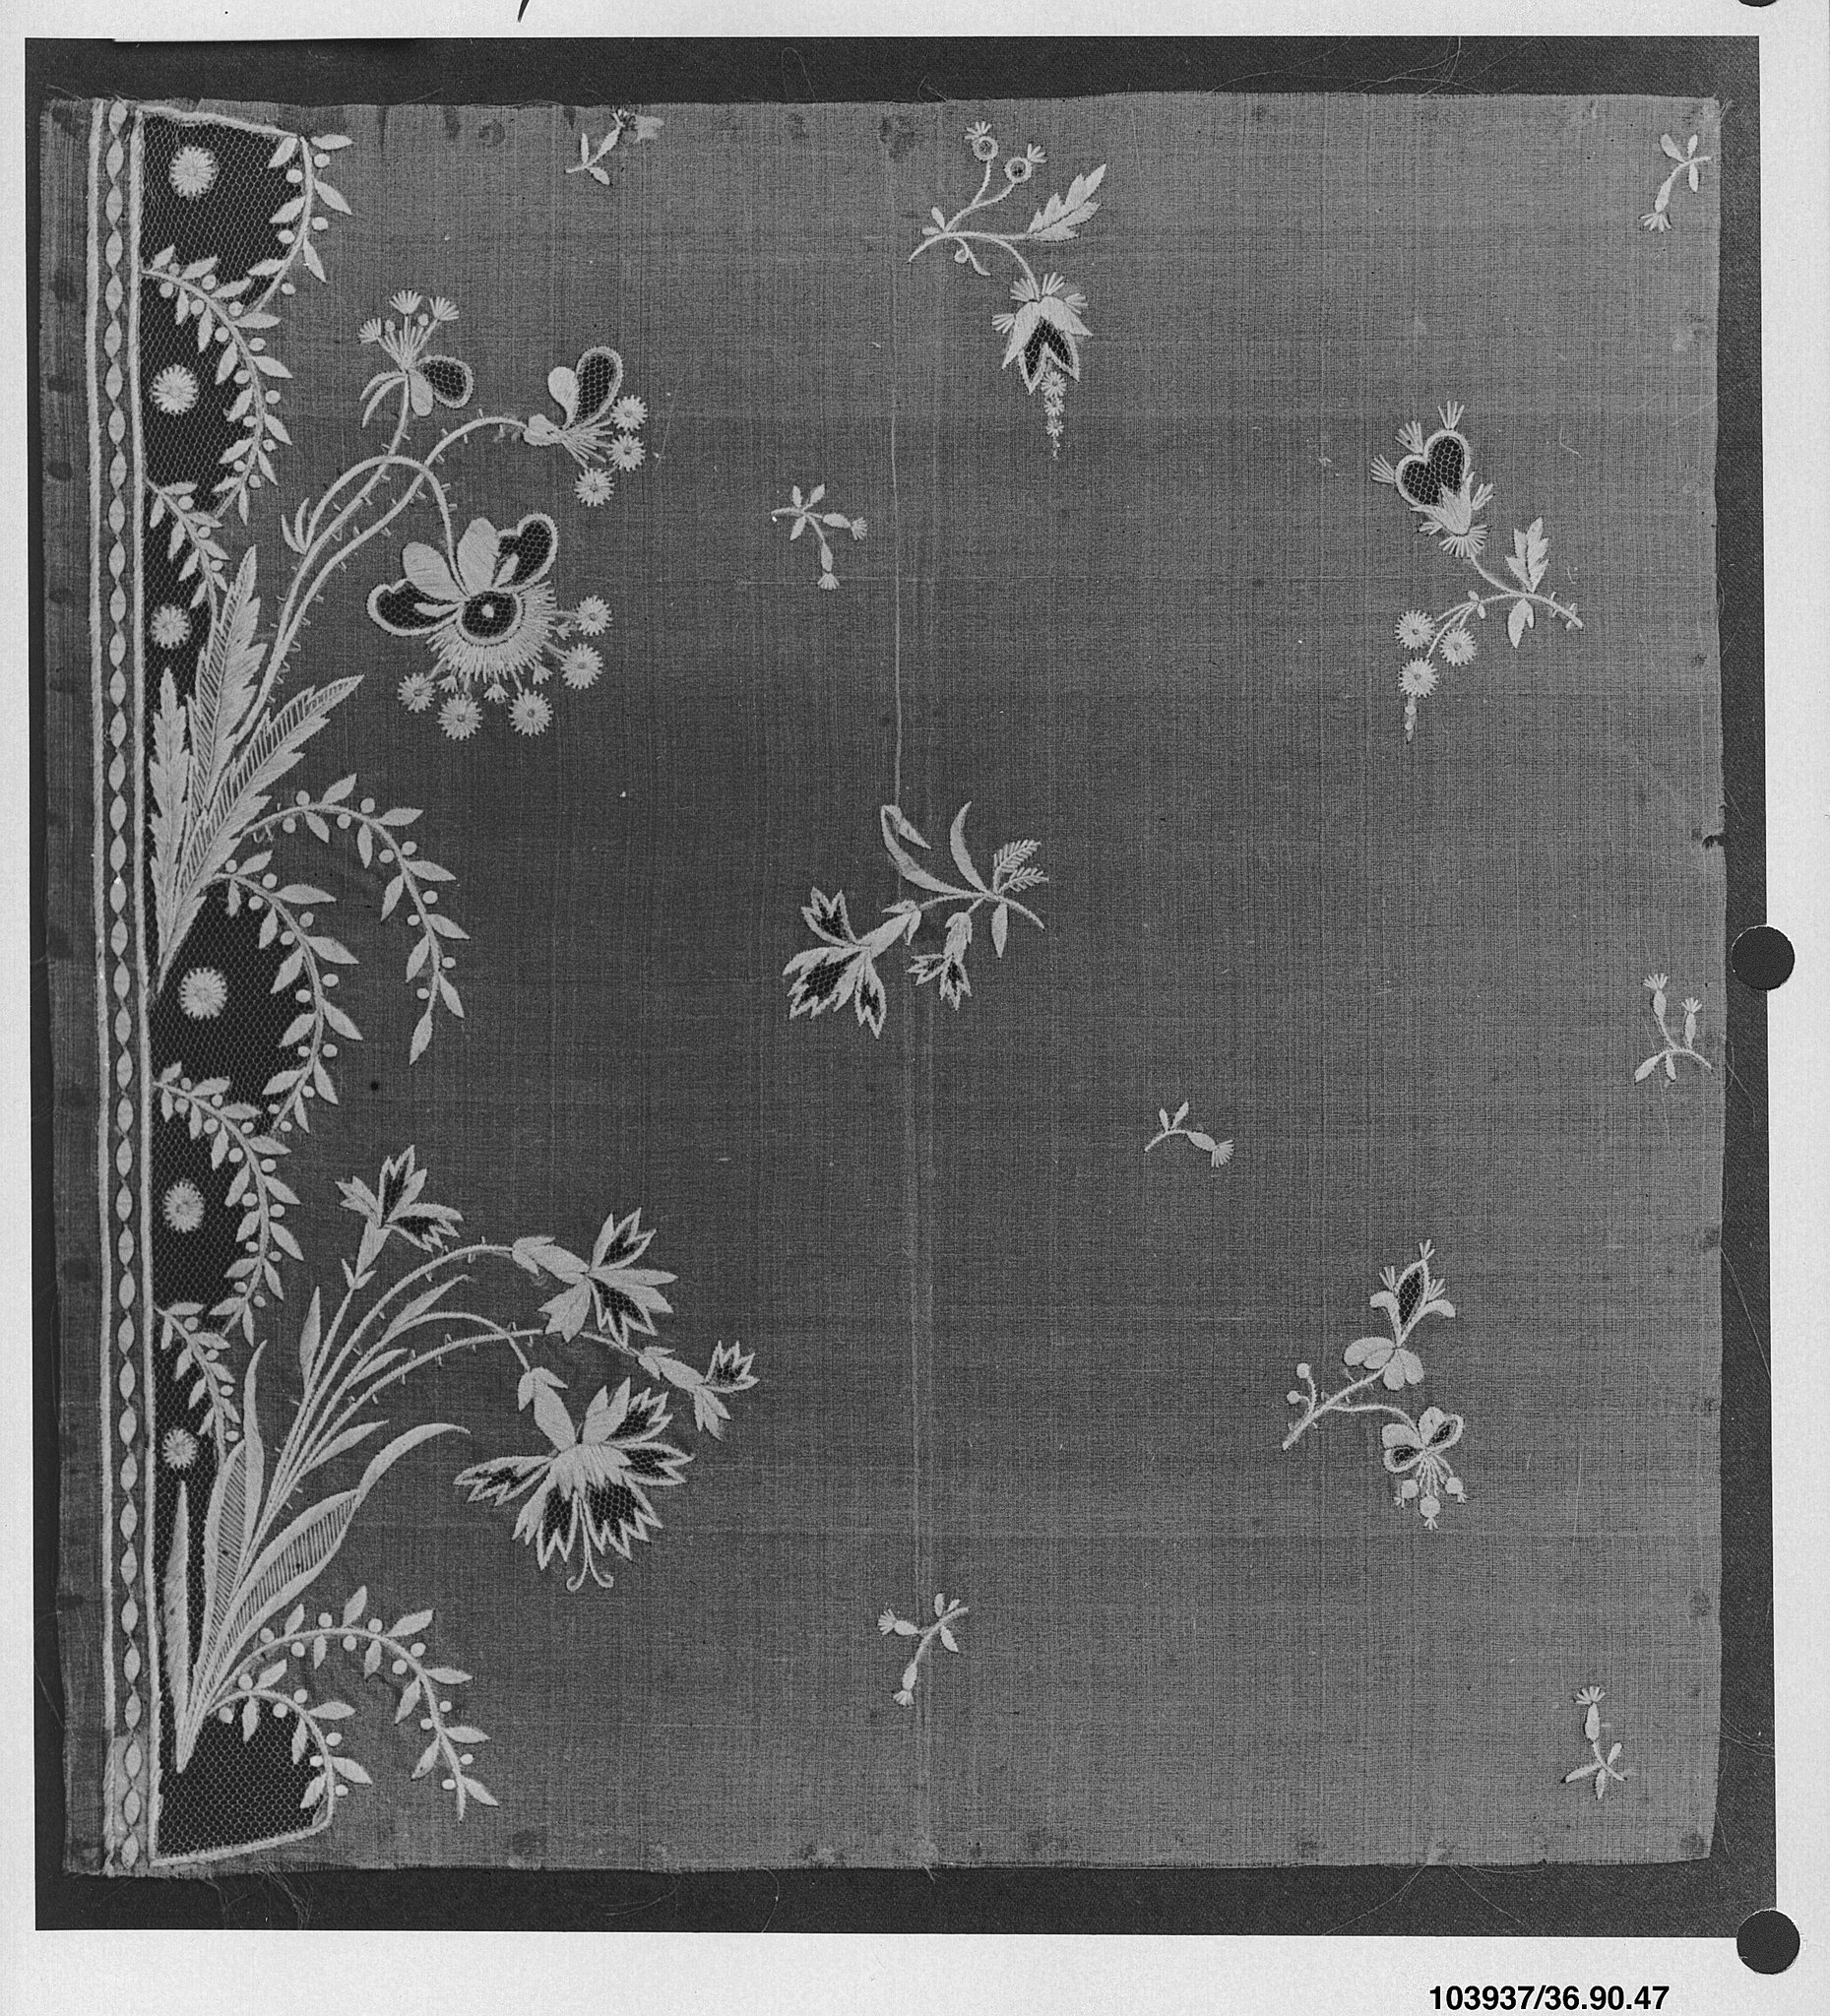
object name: border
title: Dress border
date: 1801-1833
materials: silk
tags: flowers